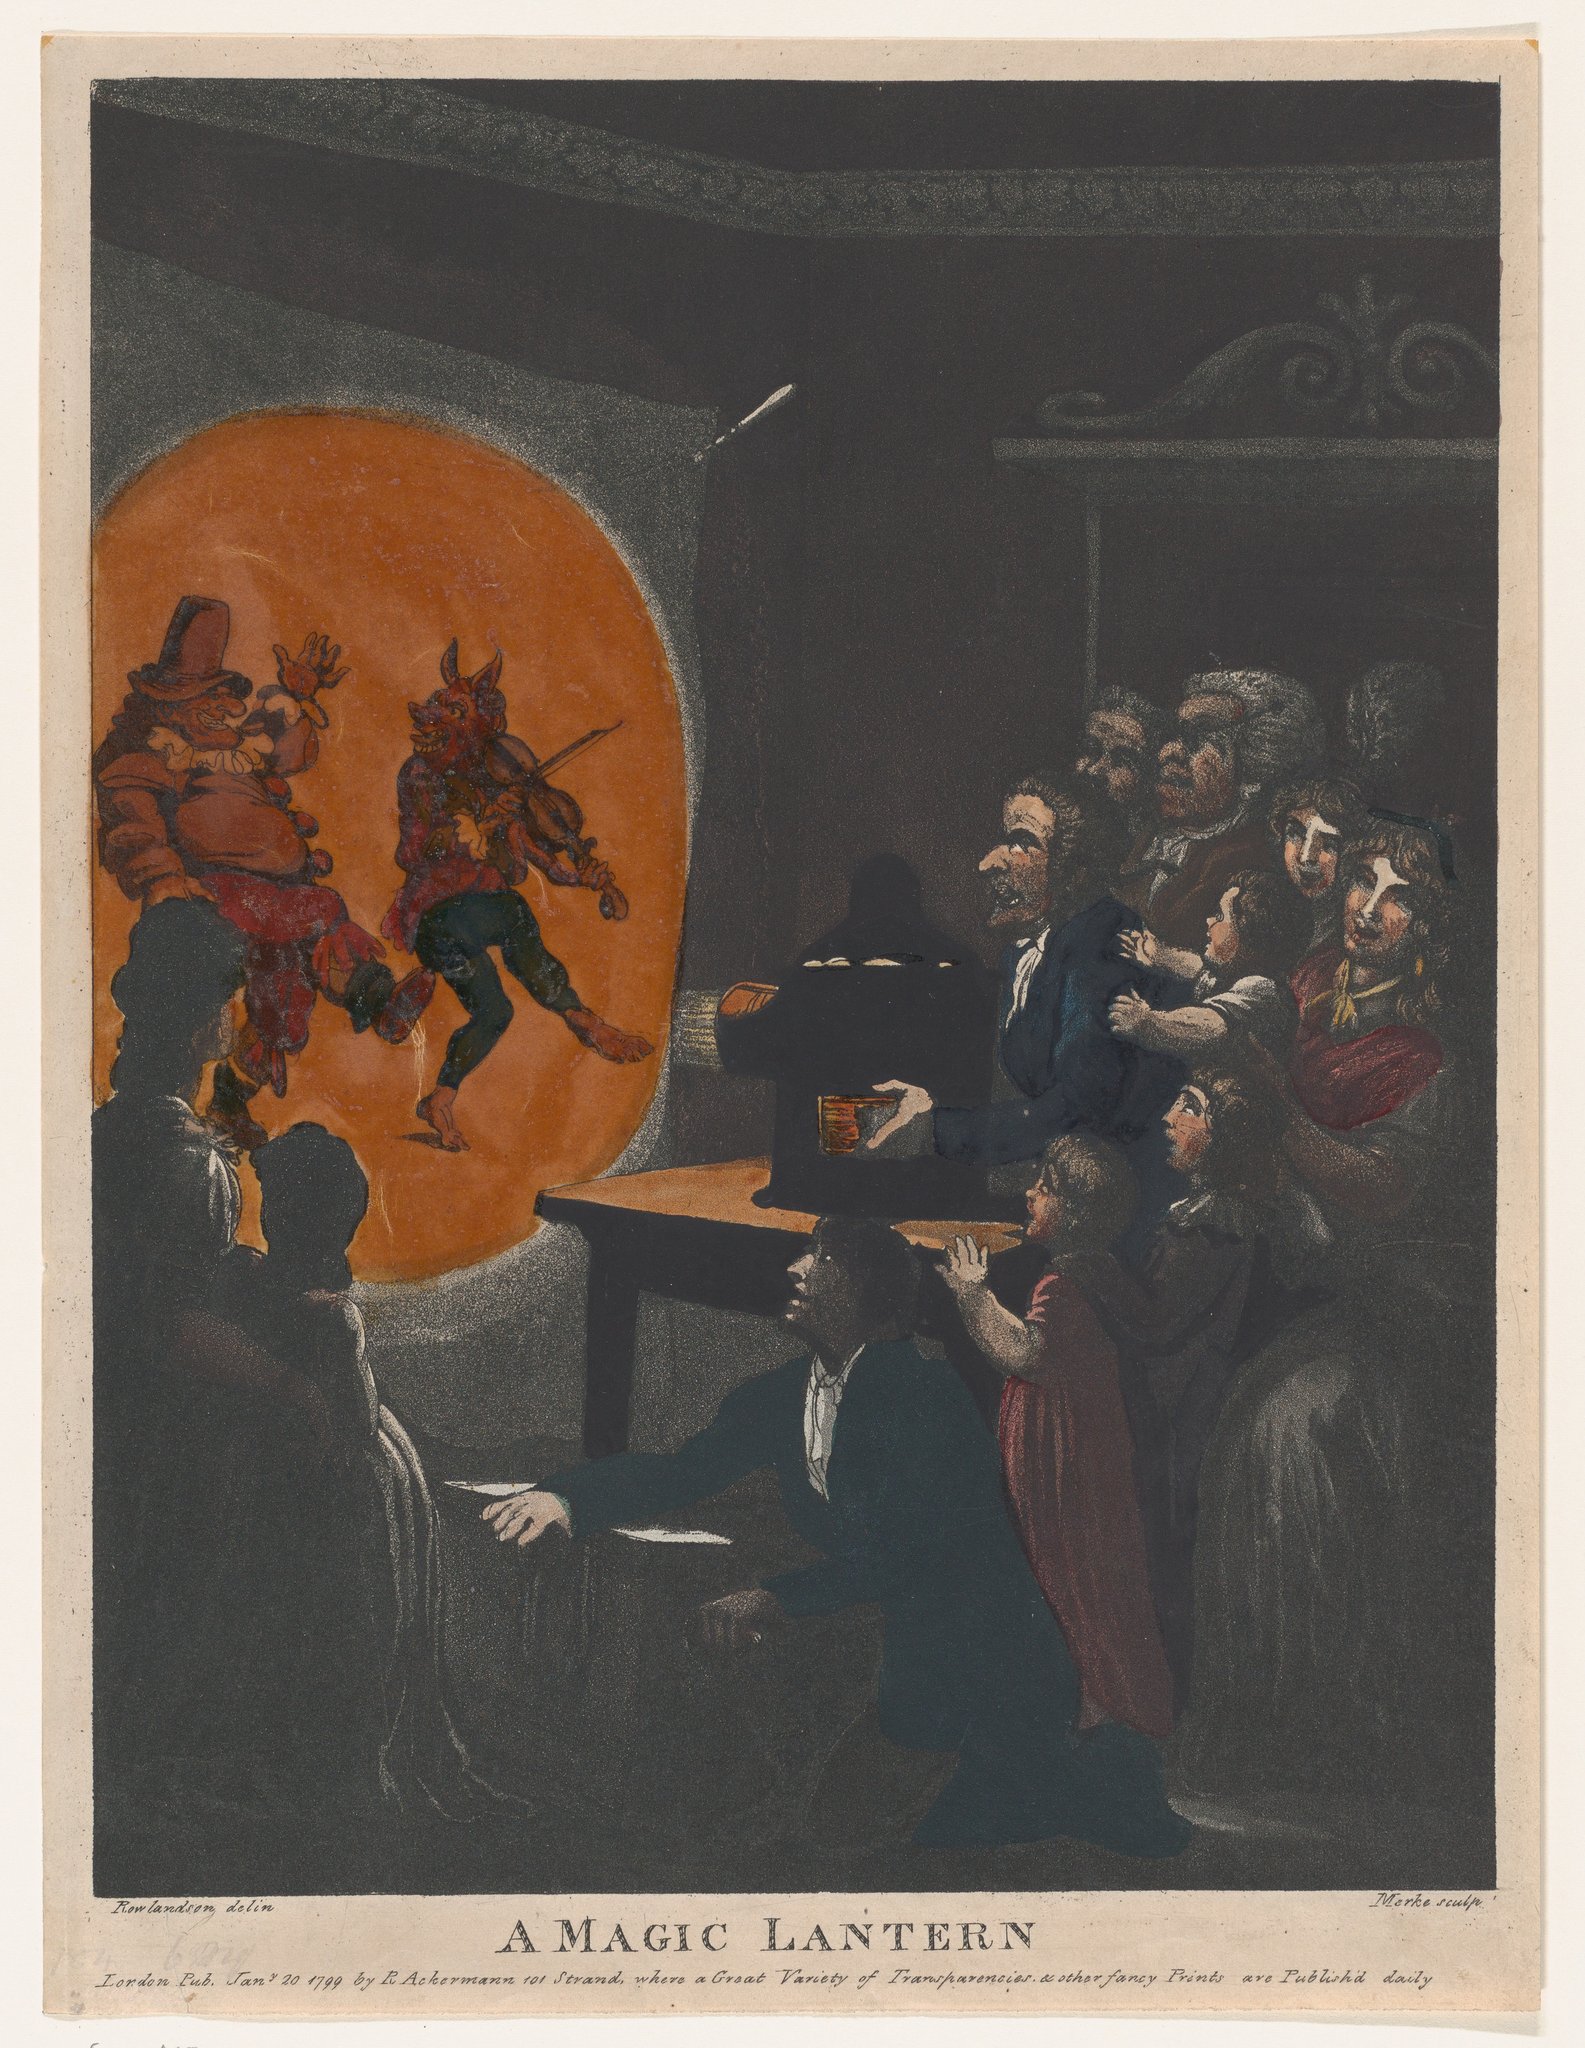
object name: print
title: A Magic Lantern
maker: henri merke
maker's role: artist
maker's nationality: swiss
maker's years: 1760-1820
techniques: aquatint, etching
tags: girls,men,women,spectators,lanterns